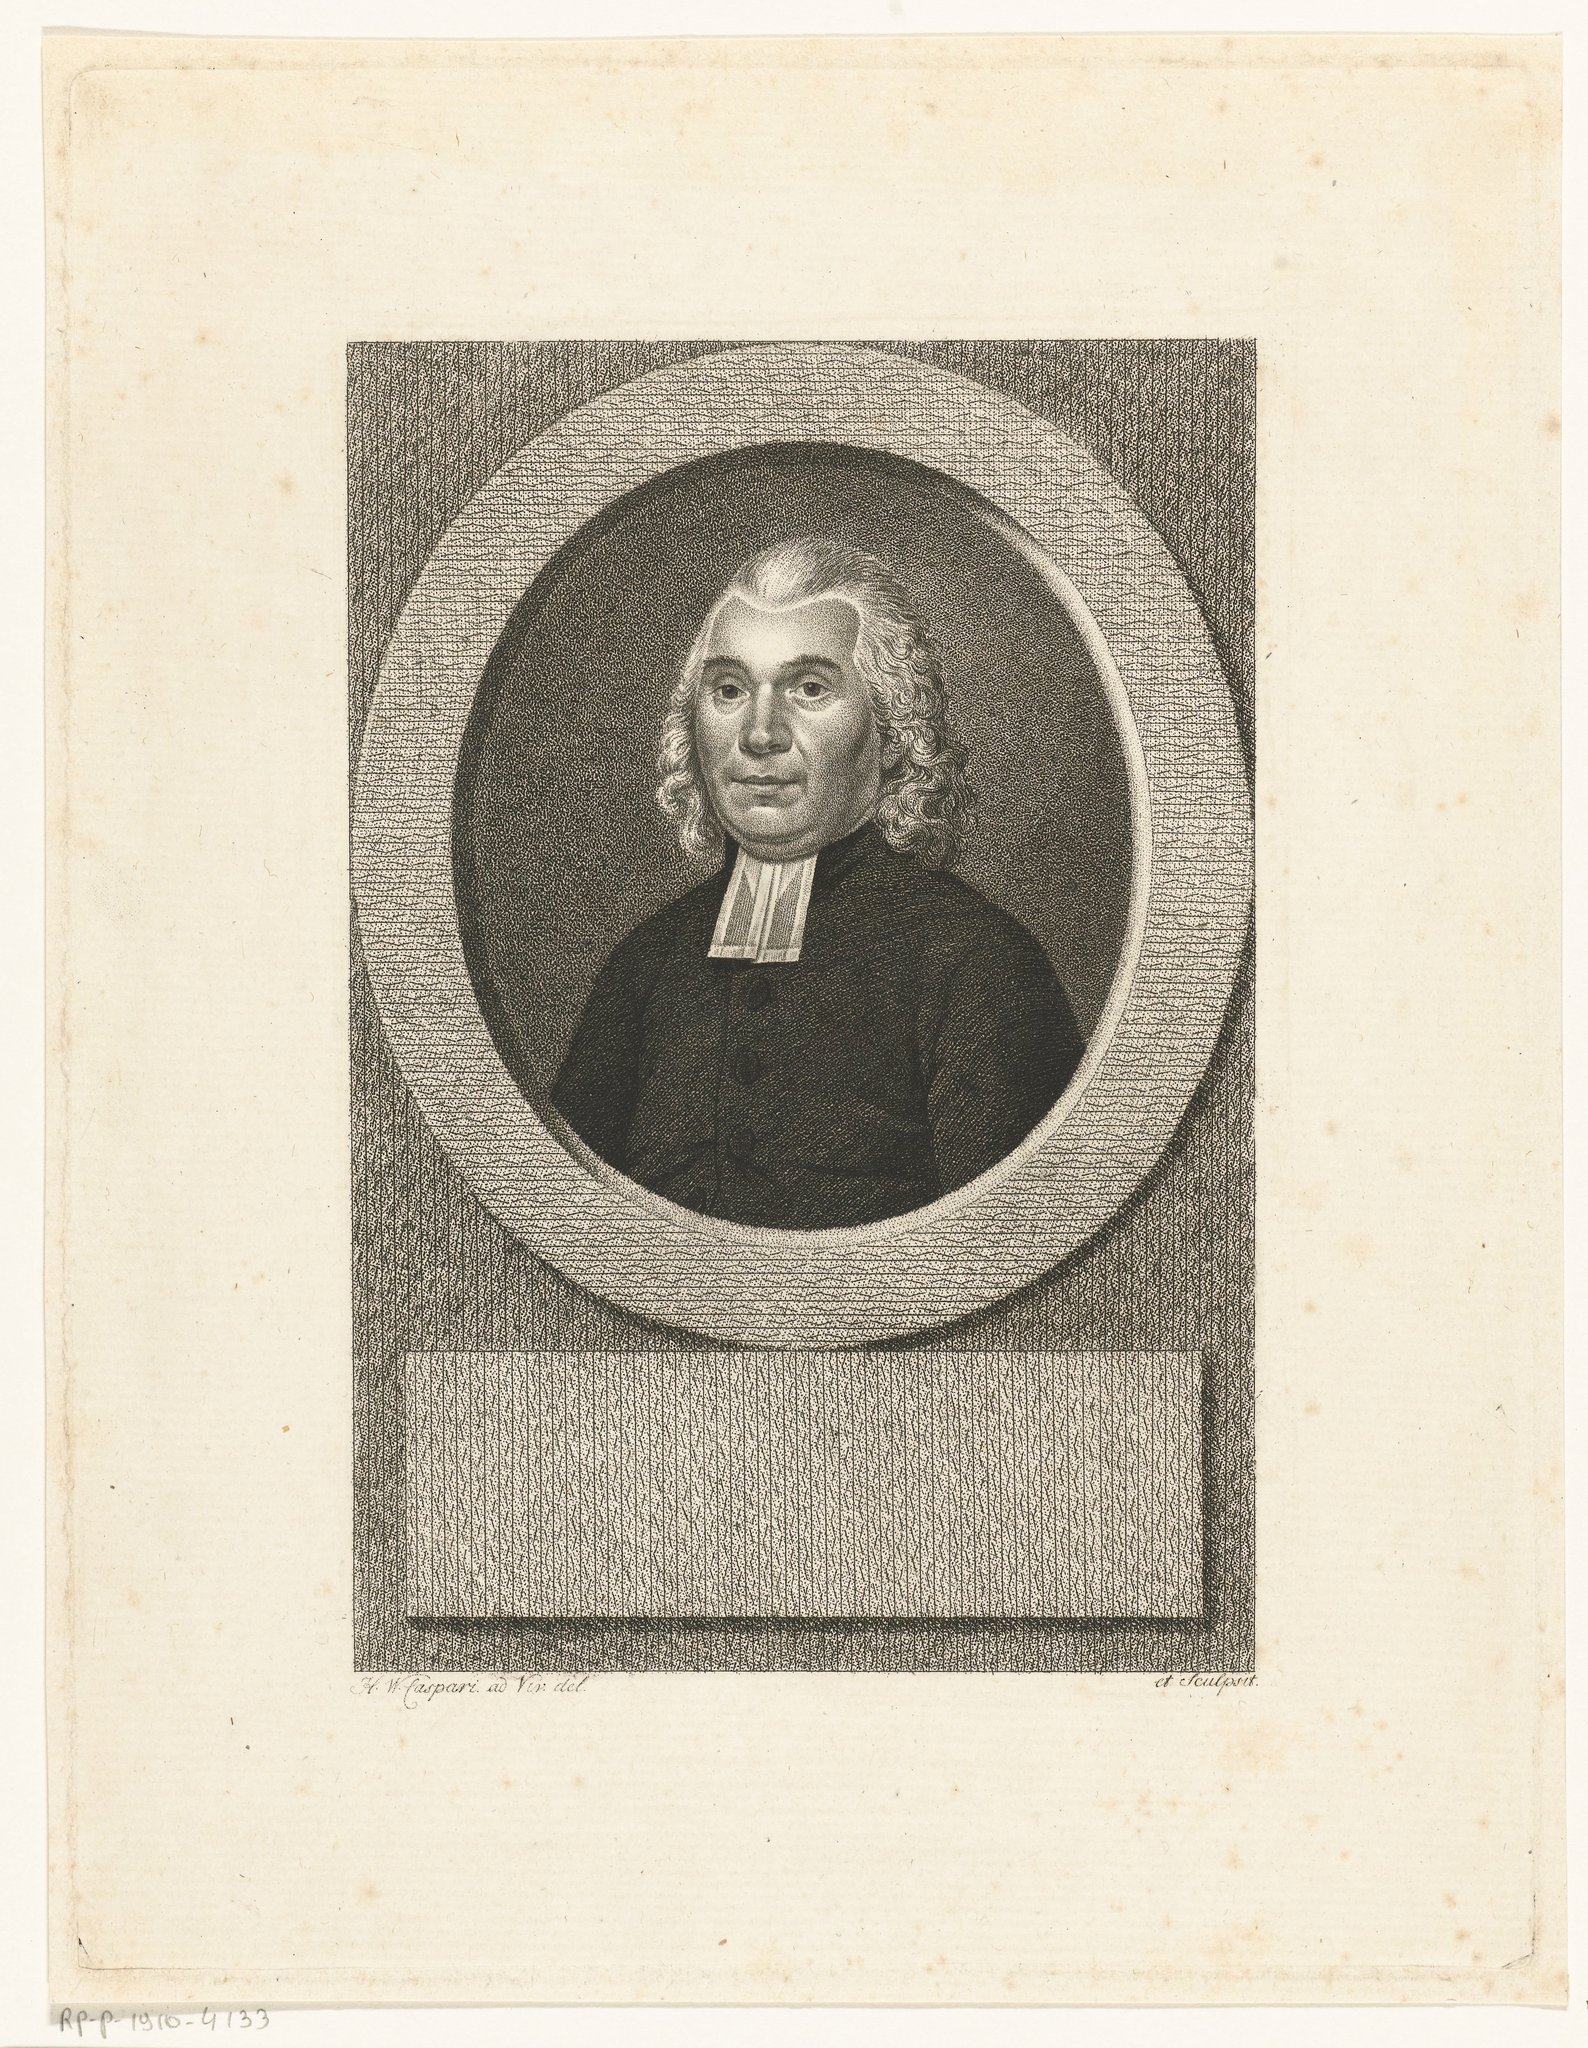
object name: print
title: Portret van Cornelis Fortuyn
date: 1803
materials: paper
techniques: etching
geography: amsterdam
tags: prediker, cornelis fortuyn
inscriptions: collector's mark: Lugt 2228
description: Omdat het kan zijn dat twee prenten van twee verschillende kunstenaars (A. Cheyere en H.W. Casari) hetzelfde nummer hebben gekregen (RP-P-1910-4133), zijn de gegevens van het inventarisboek (die de prent toewijst aan Cheyere) nog niet gewist.